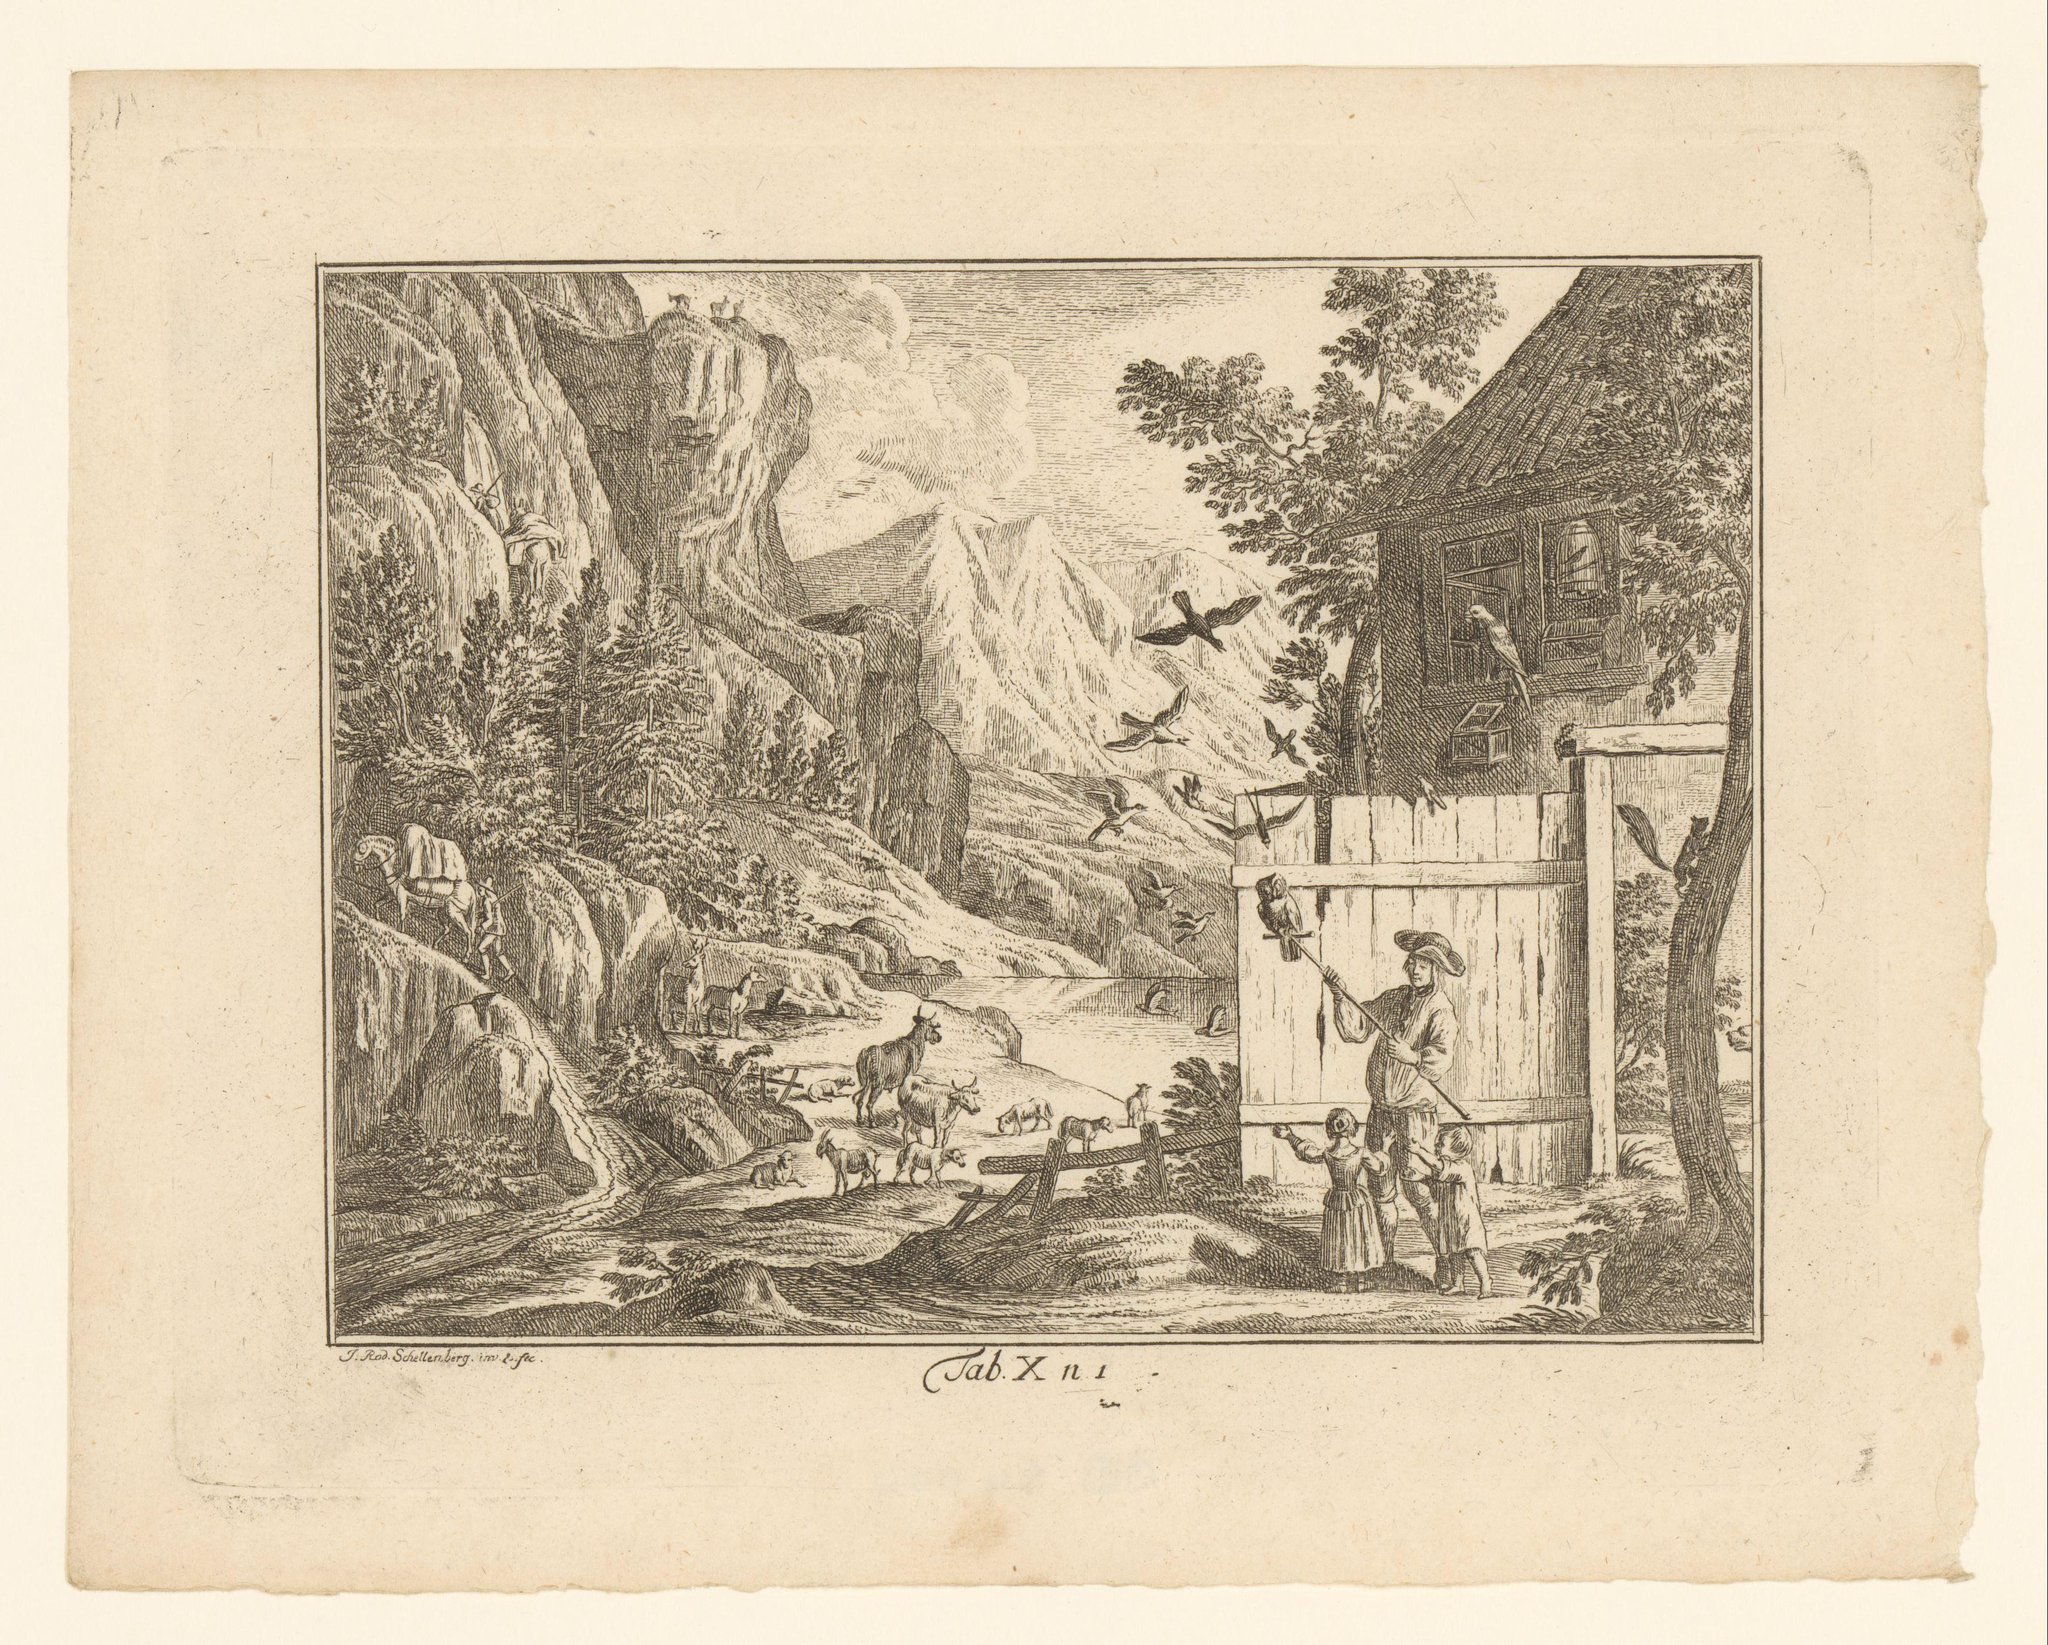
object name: print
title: Wetenschappelijke voorstelling van dieren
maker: johann rudolph schellenberg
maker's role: print maker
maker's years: 1740-1806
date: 1784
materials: paper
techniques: etching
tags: owls, zoology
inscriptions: collector's mark: Lugt 2228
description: Prent ook gebruikt in: Stoy, Johann Sigmund. Bilder-Akademie für die Jugend. Neurenberg: Johann Sigmund Stoy, 1784.